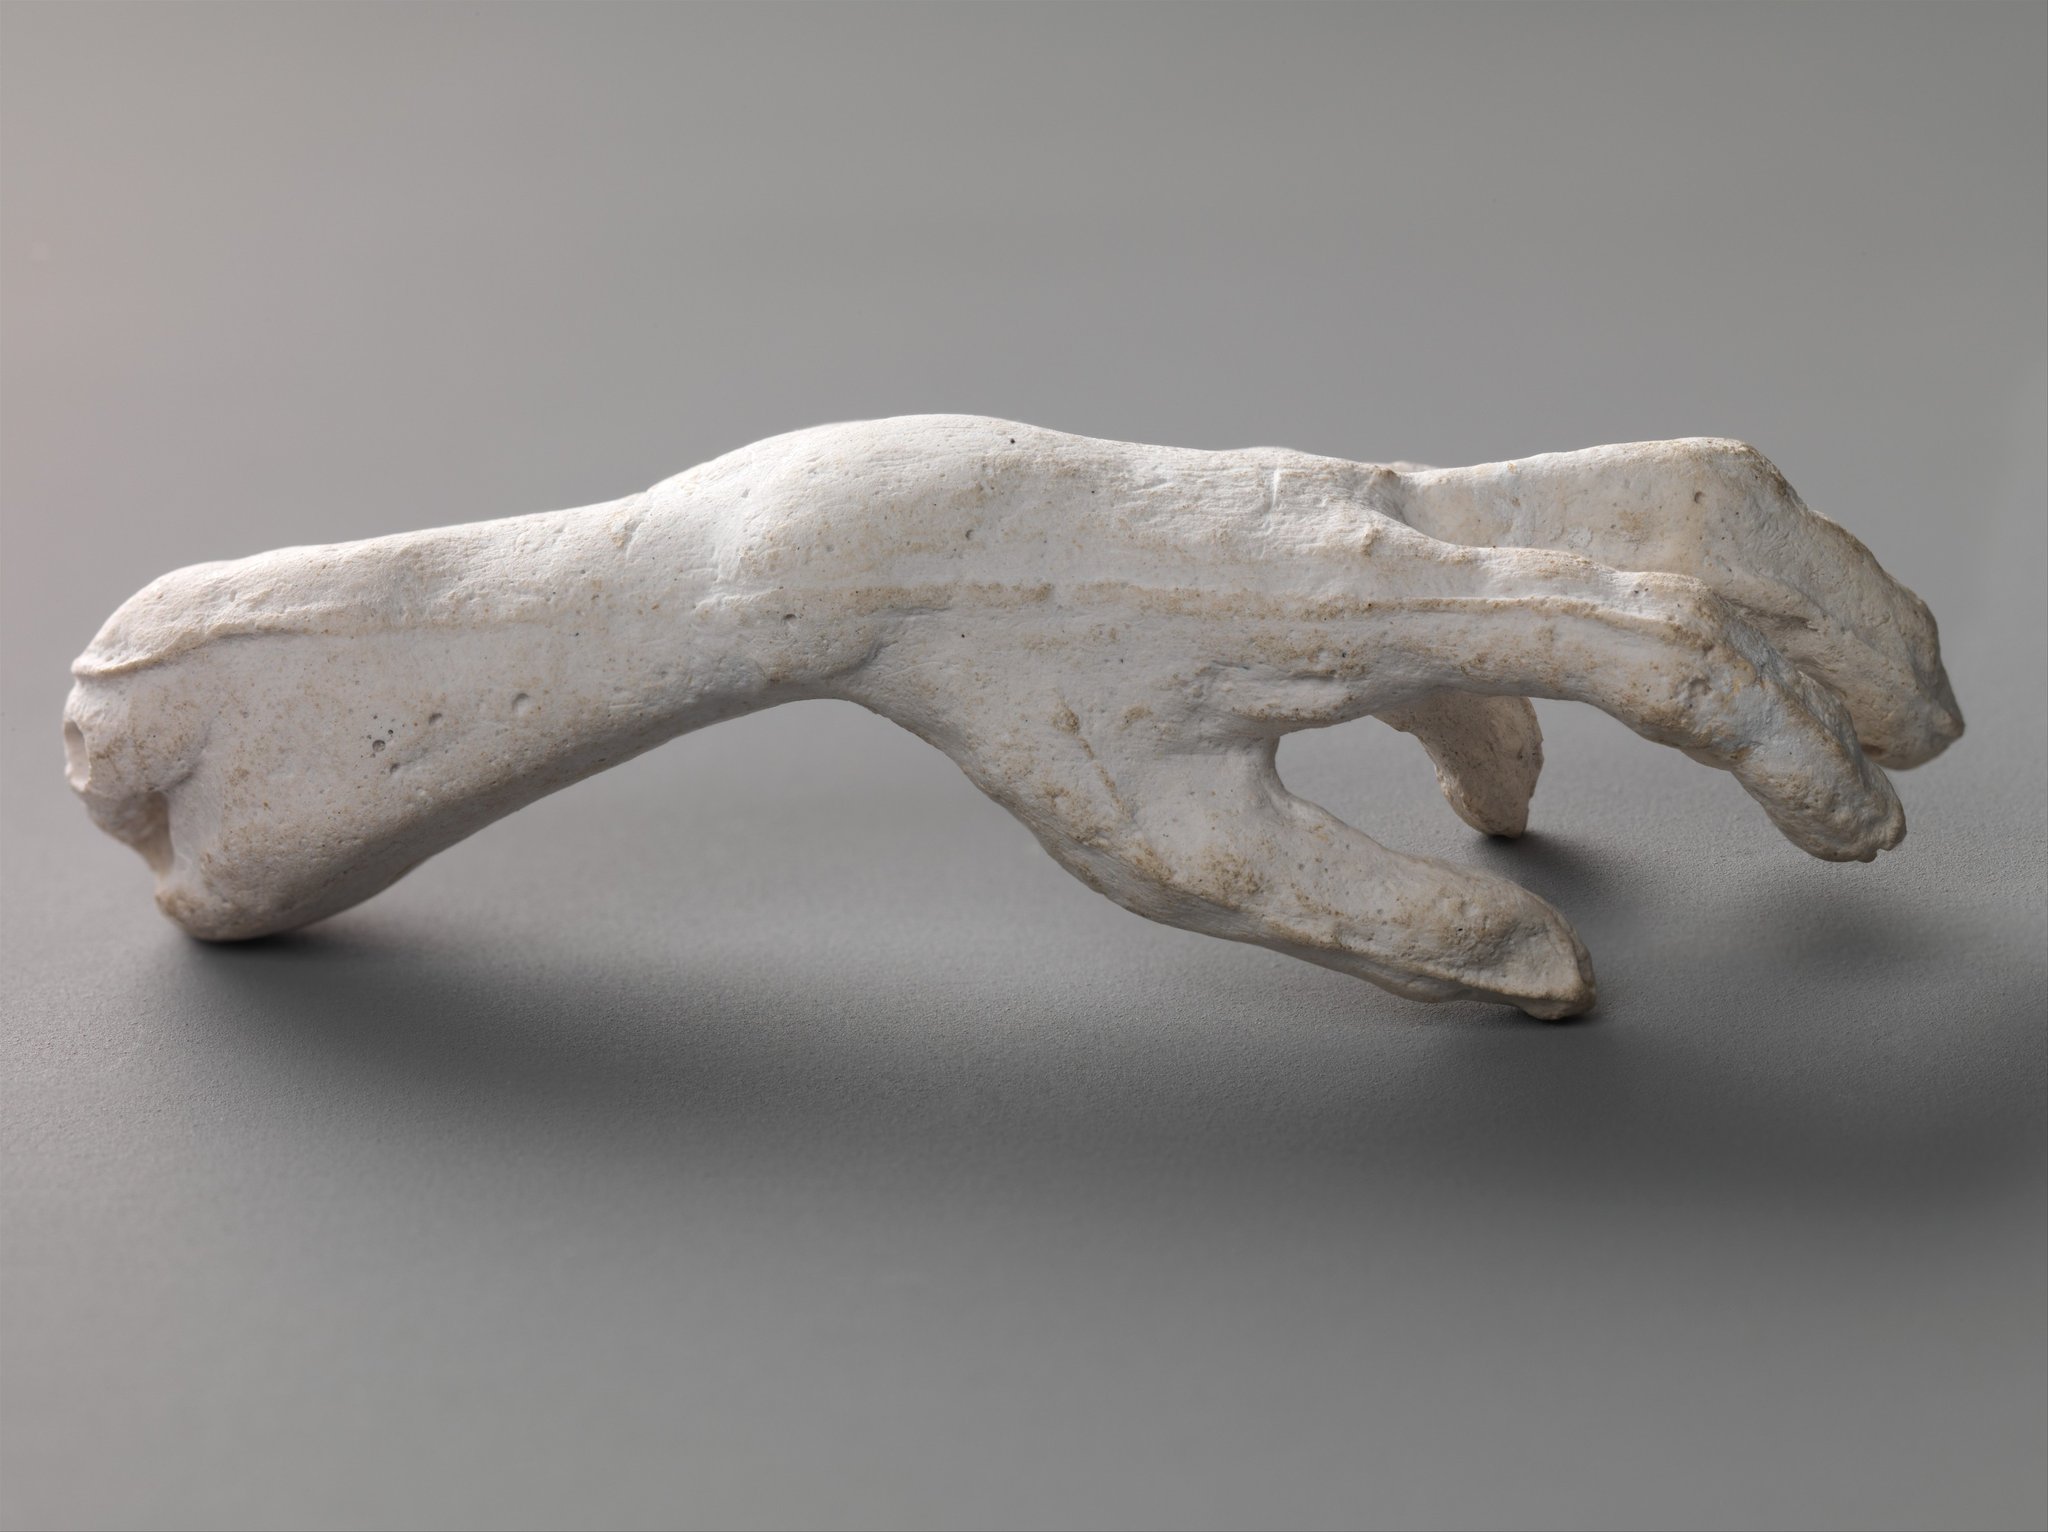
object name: cast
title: Study of a hand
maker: auguste rodin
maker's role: artist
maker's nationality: french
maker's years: 1840-1917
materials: plaster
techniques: casting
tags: hands